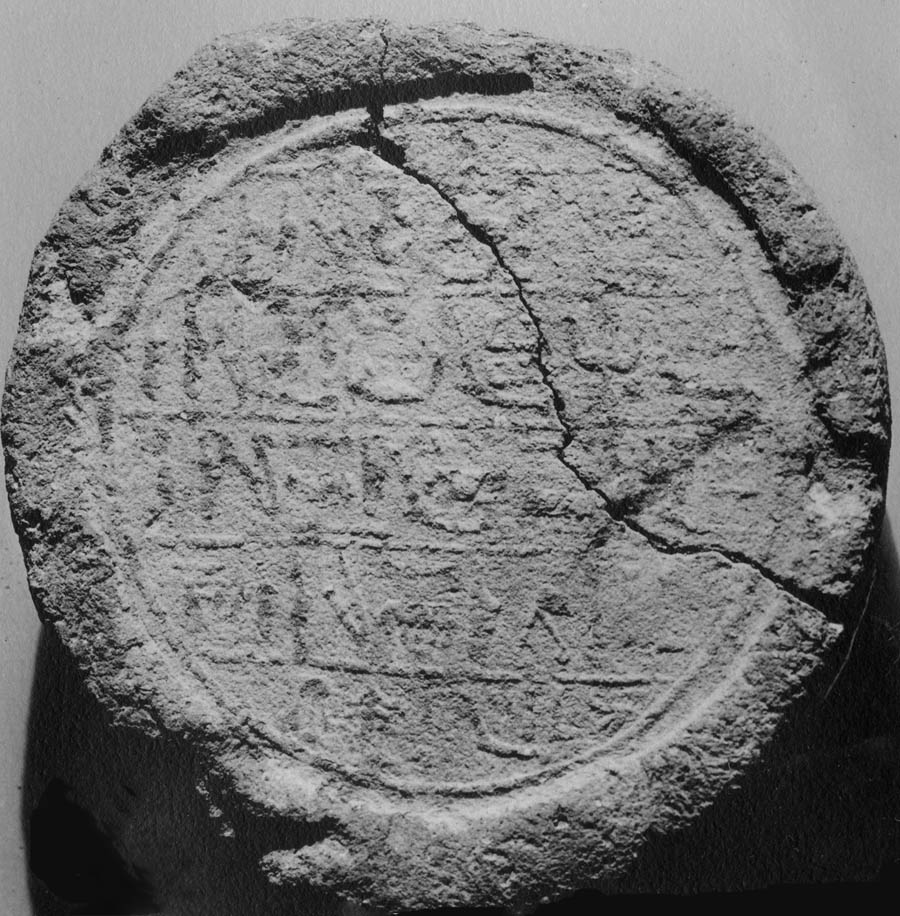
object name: cone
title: Funerary Cone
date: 1550-1295 BCE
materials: pottery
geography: egypt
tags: hieroglyphs